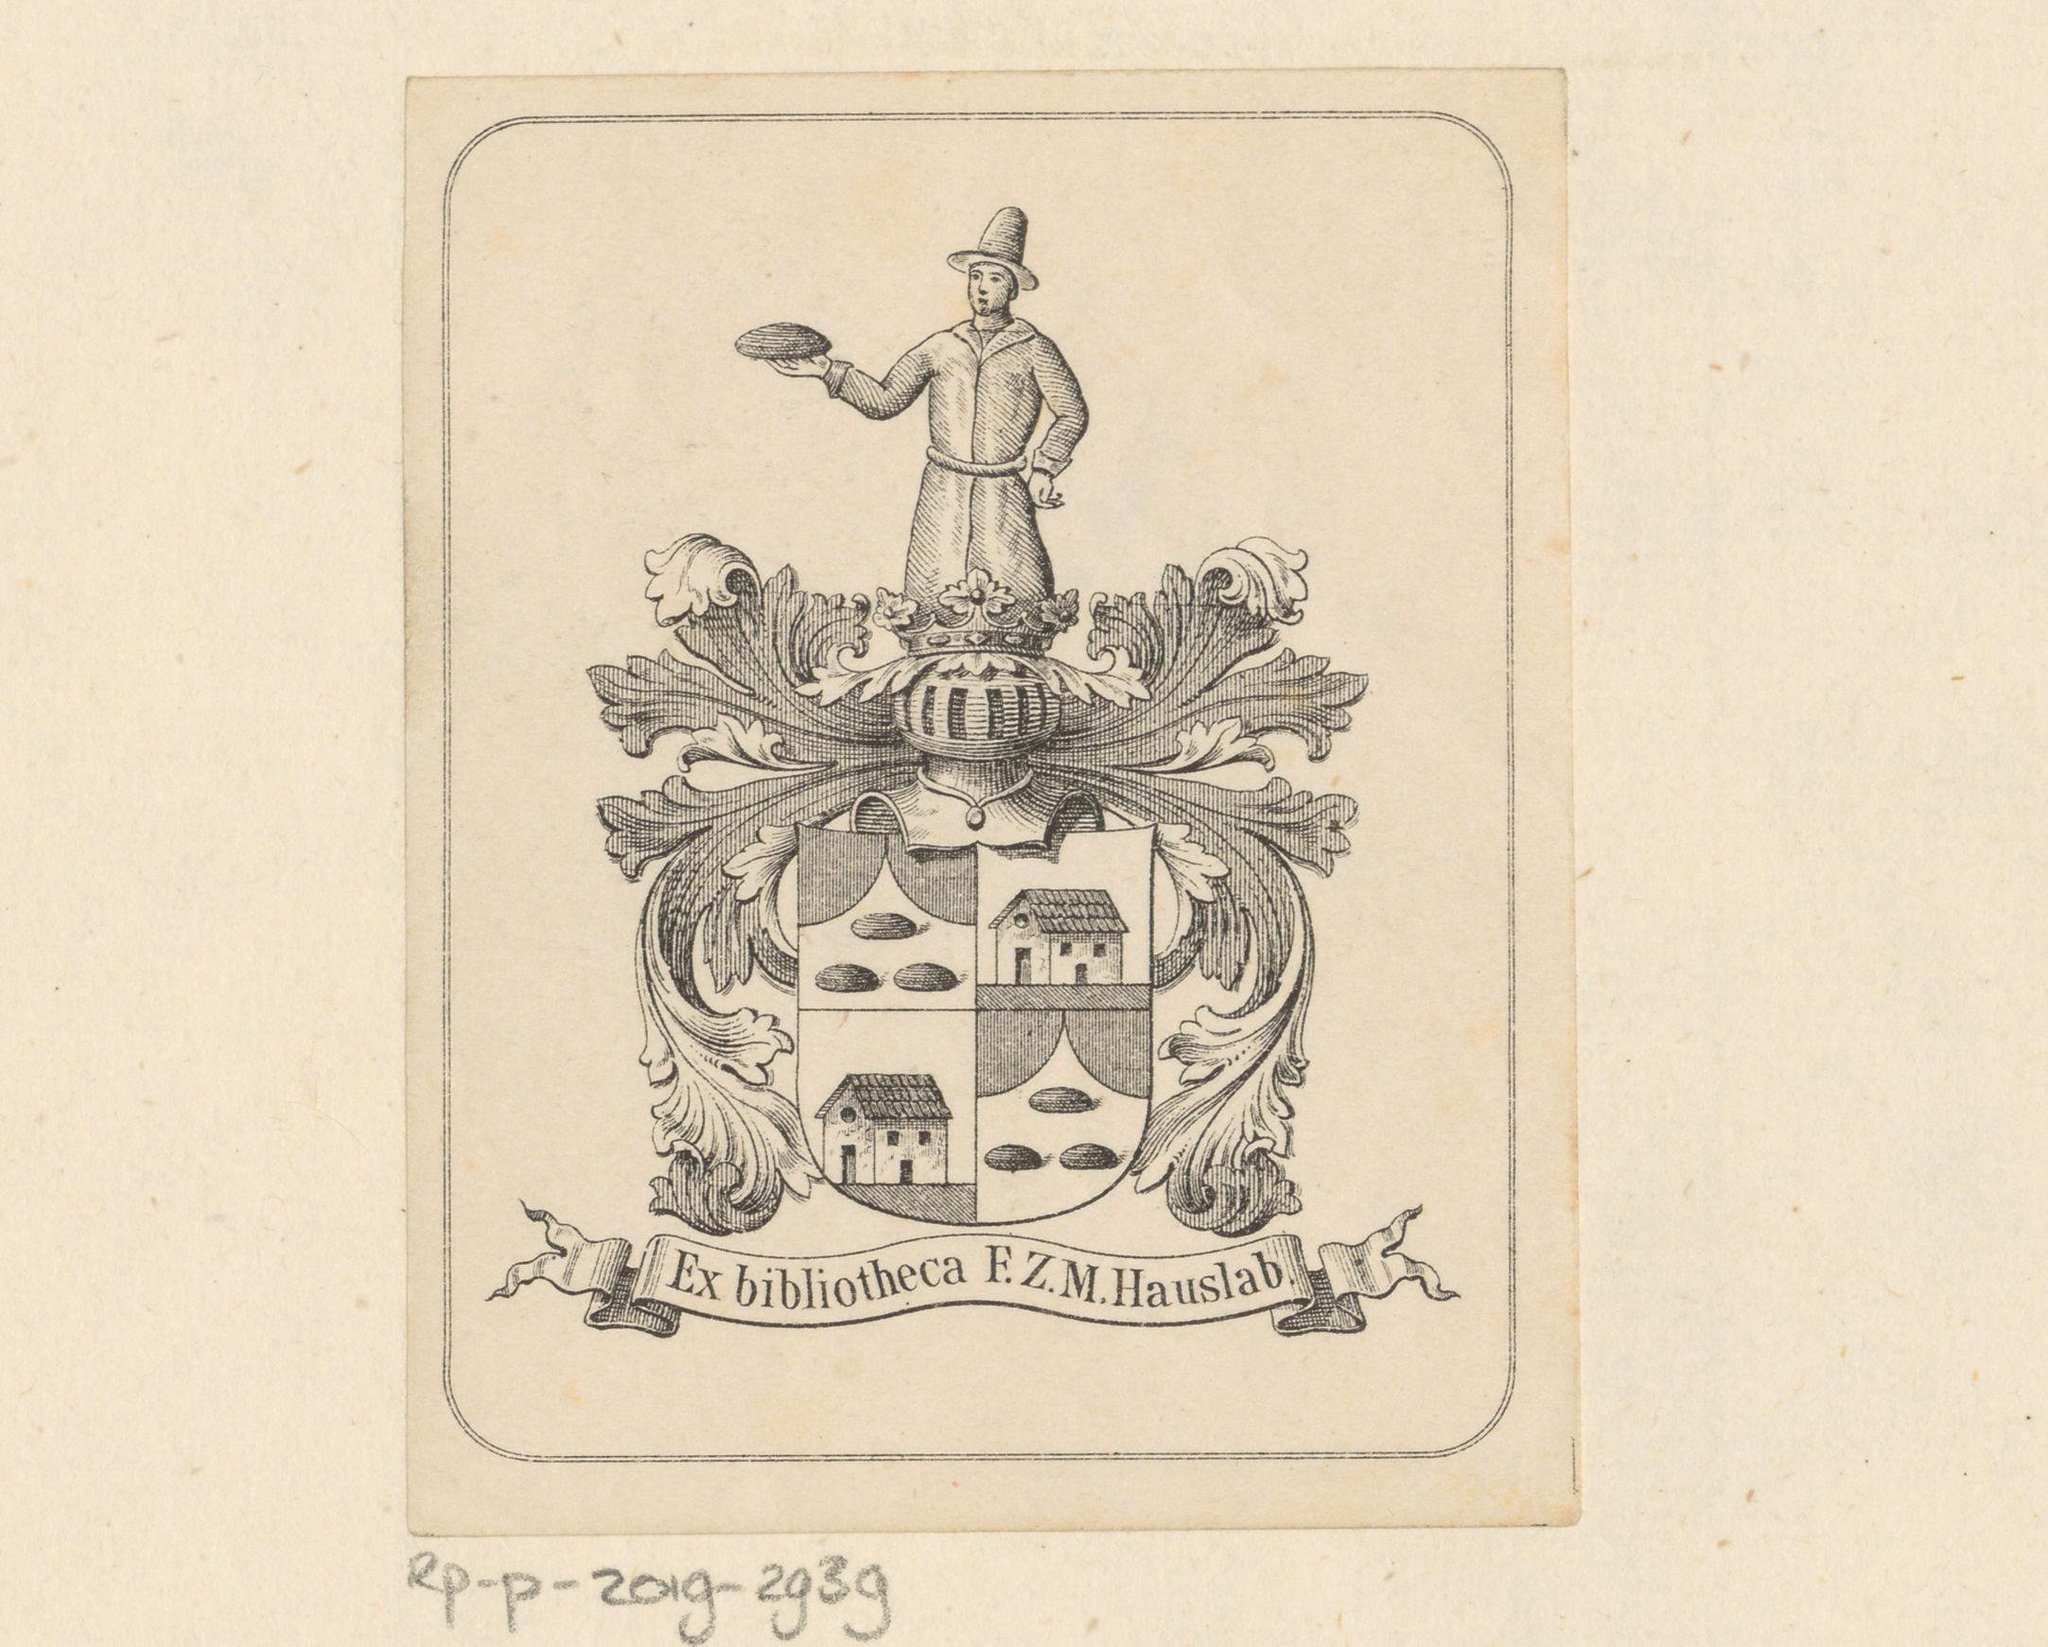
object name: bookplate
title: Ex libris van F.Z.M. Hauslab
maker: Anonymous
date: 1808-1883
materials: paper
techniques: etching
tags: vienna, armorial bearing, heraldry